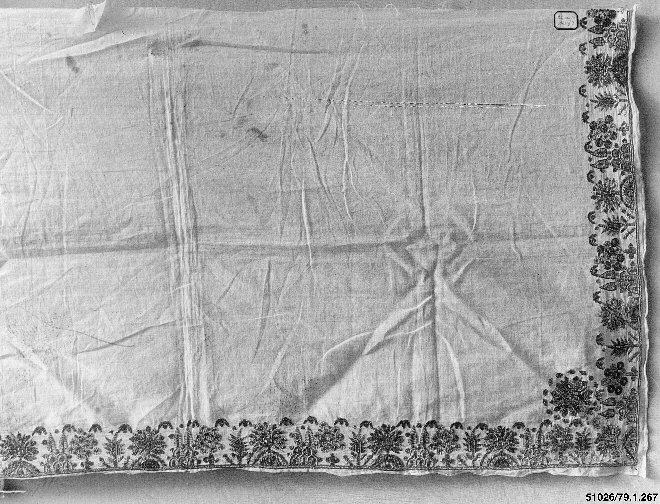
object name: cover fragment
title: Fragment of a Cover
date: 1801-1833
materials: cotton, linen, metal thread, silk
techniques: embroidery, weave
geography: turkey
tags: flowers